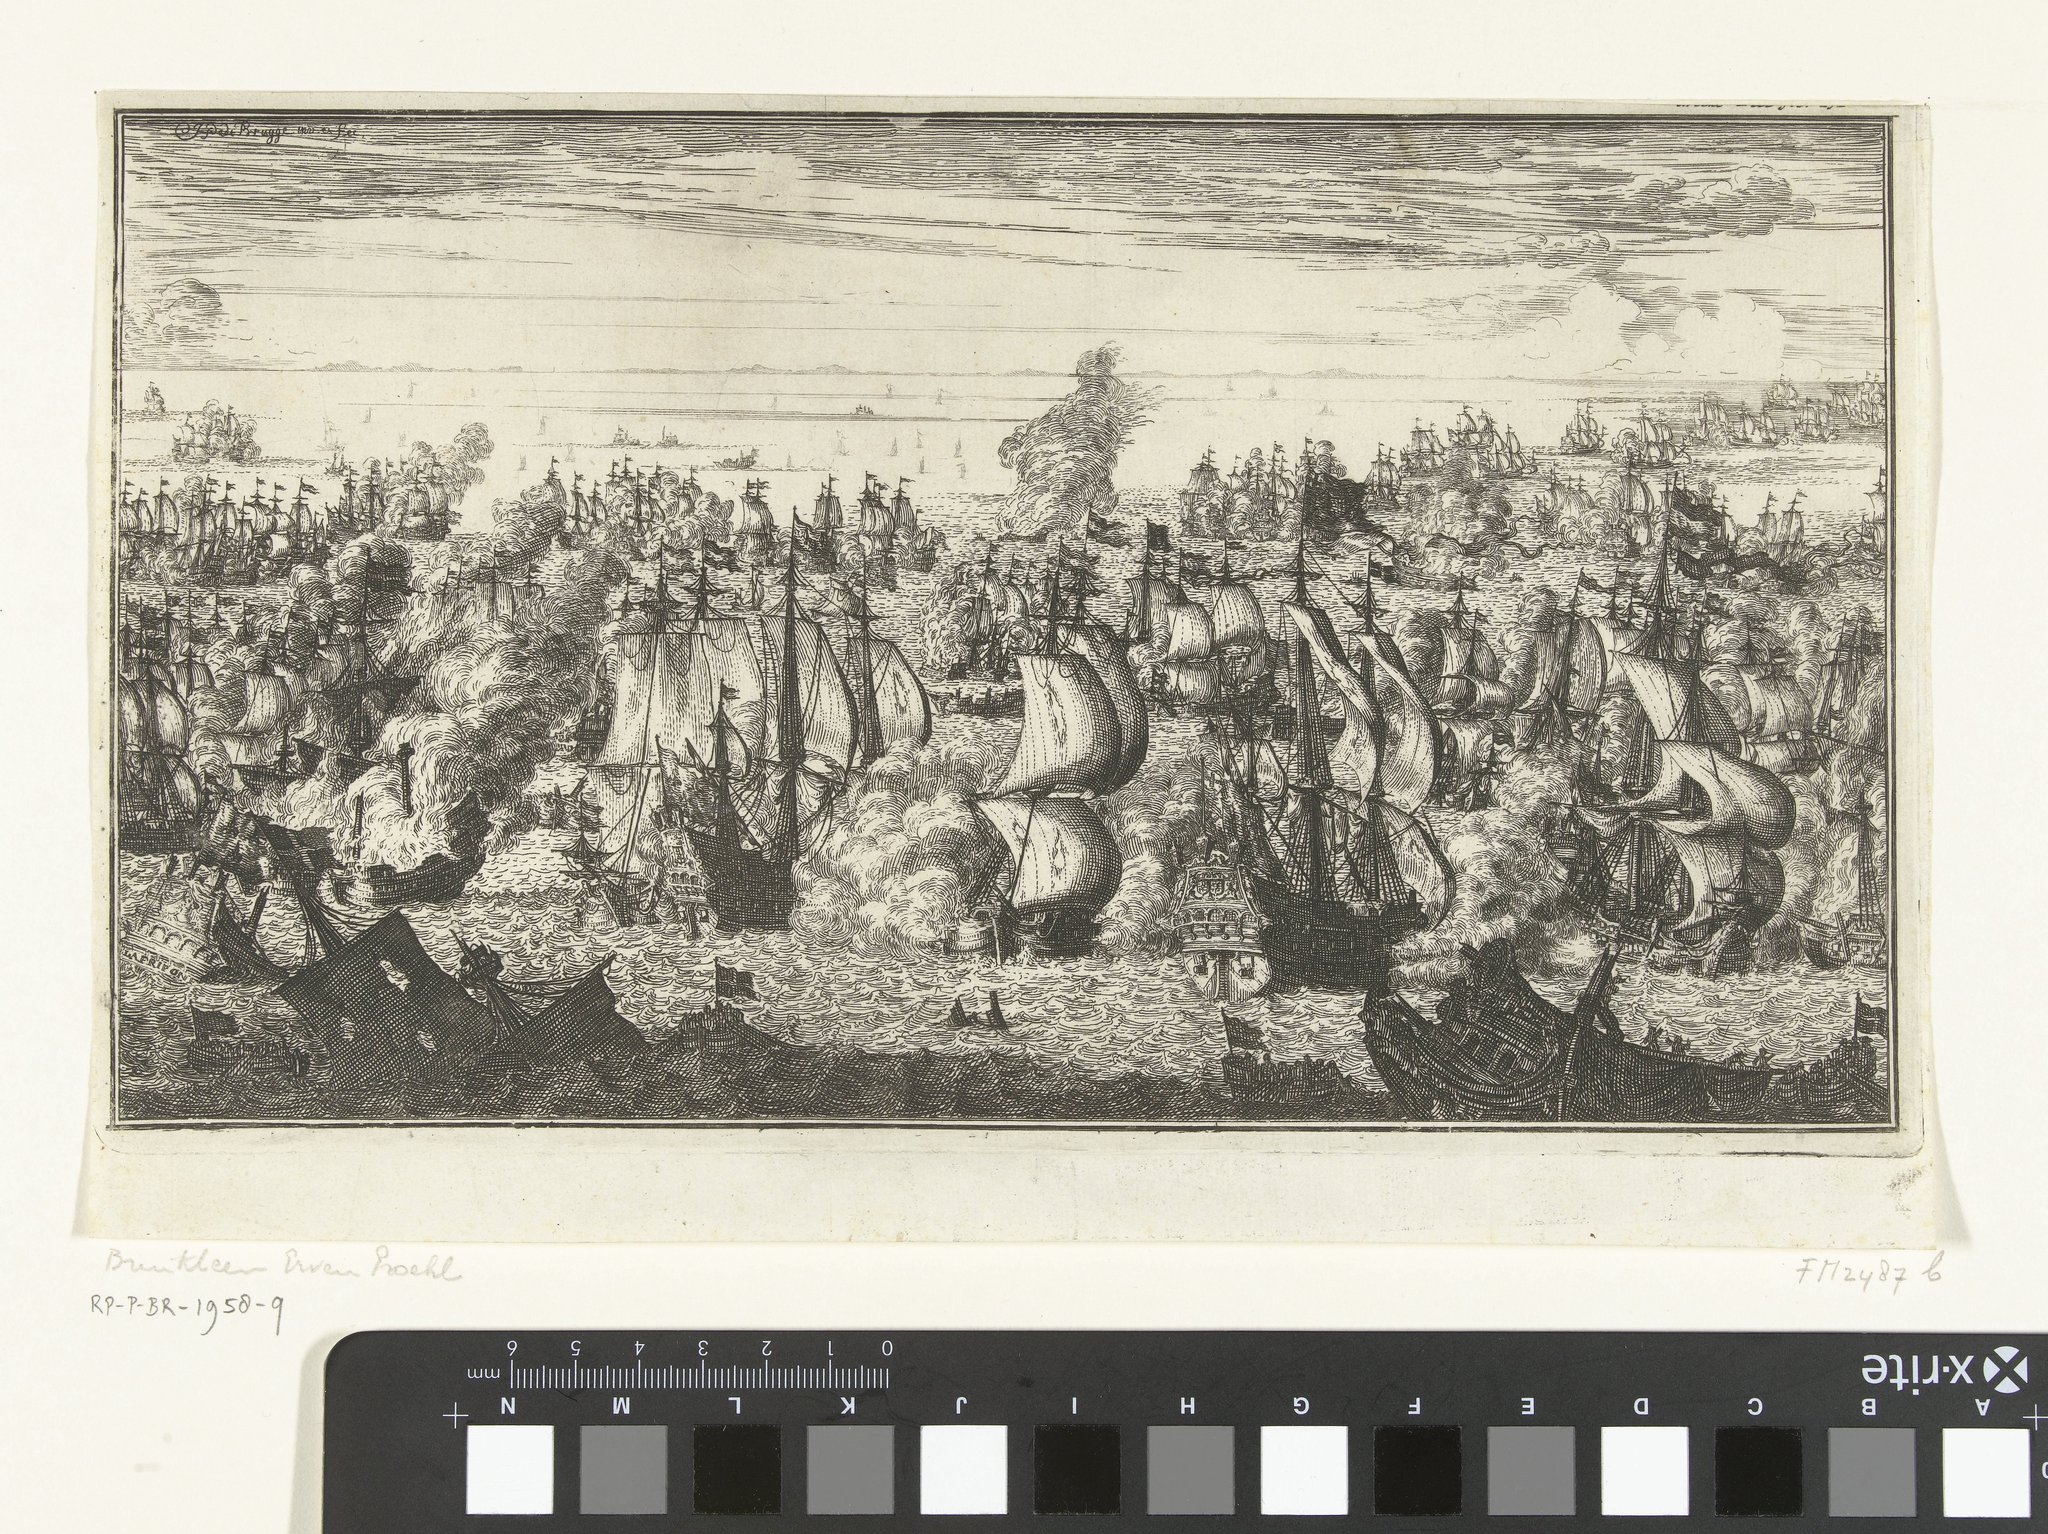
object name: print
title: Zeeslag bij Kijkduin, 21 augustus 1673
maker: herman padtbrugge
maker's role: print maker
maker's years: 1656-1687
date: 1674-1676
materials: paper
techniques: etching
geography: northern netherlands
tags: prague, london, print maker, draughtsman, prinz ruprecht, flushing, michiel adriaenszoon de ruyter, rotterdam, cornelis tromp, battle (+ naval force), battle of the texel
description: Zeeslag bij Kijkduin (bij Texel) op 21 augustus 1673 tussen de Staatse vloot onder Michiel Adriaenszoon de Ruyter en Cornelis Tromp en de Engels-Franse vloot onder prins Rupert en graaf Jean d'Estrées (II).